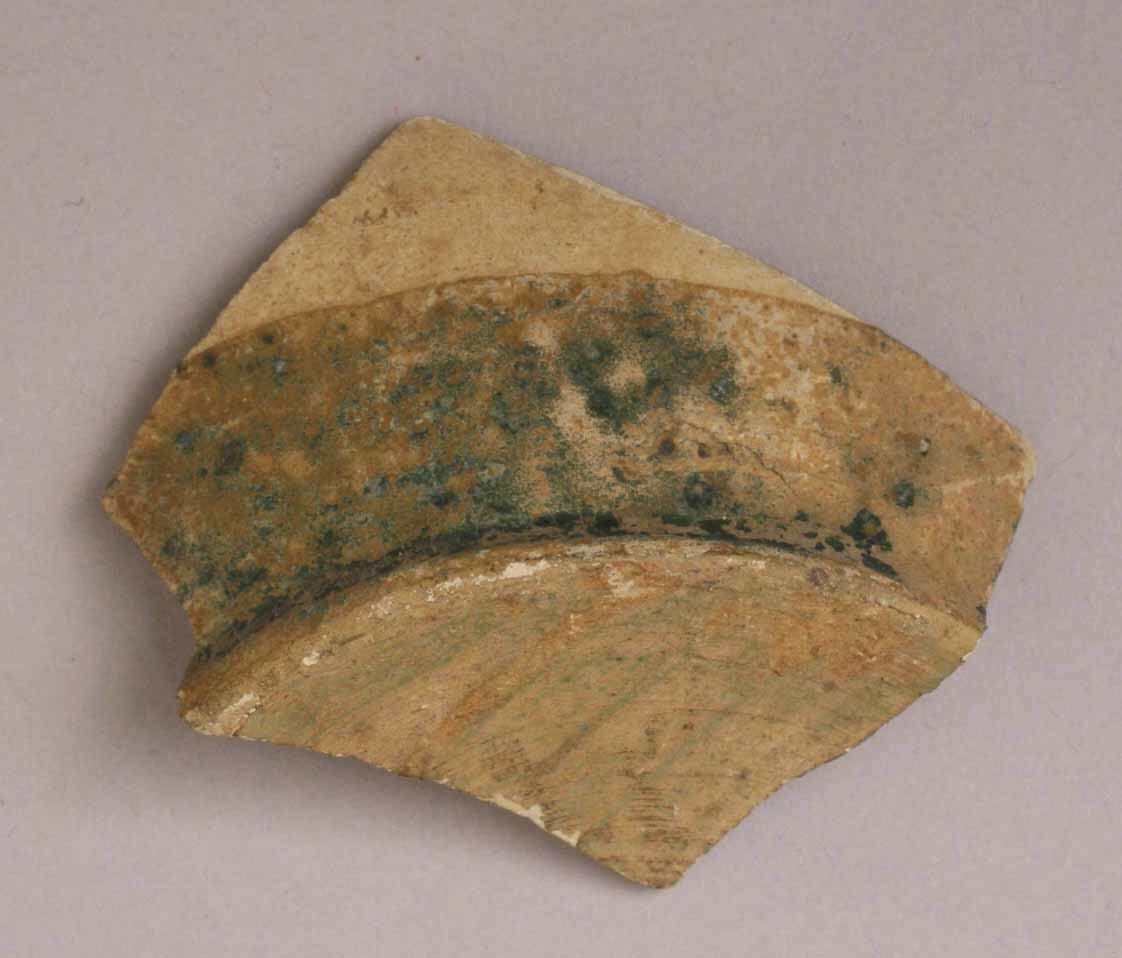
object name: fragment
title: Glazed Ceramic Fragments: Splashed, Opacified White, and Green Glazed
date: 801-900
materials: earthenware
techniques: glazing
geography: iraq